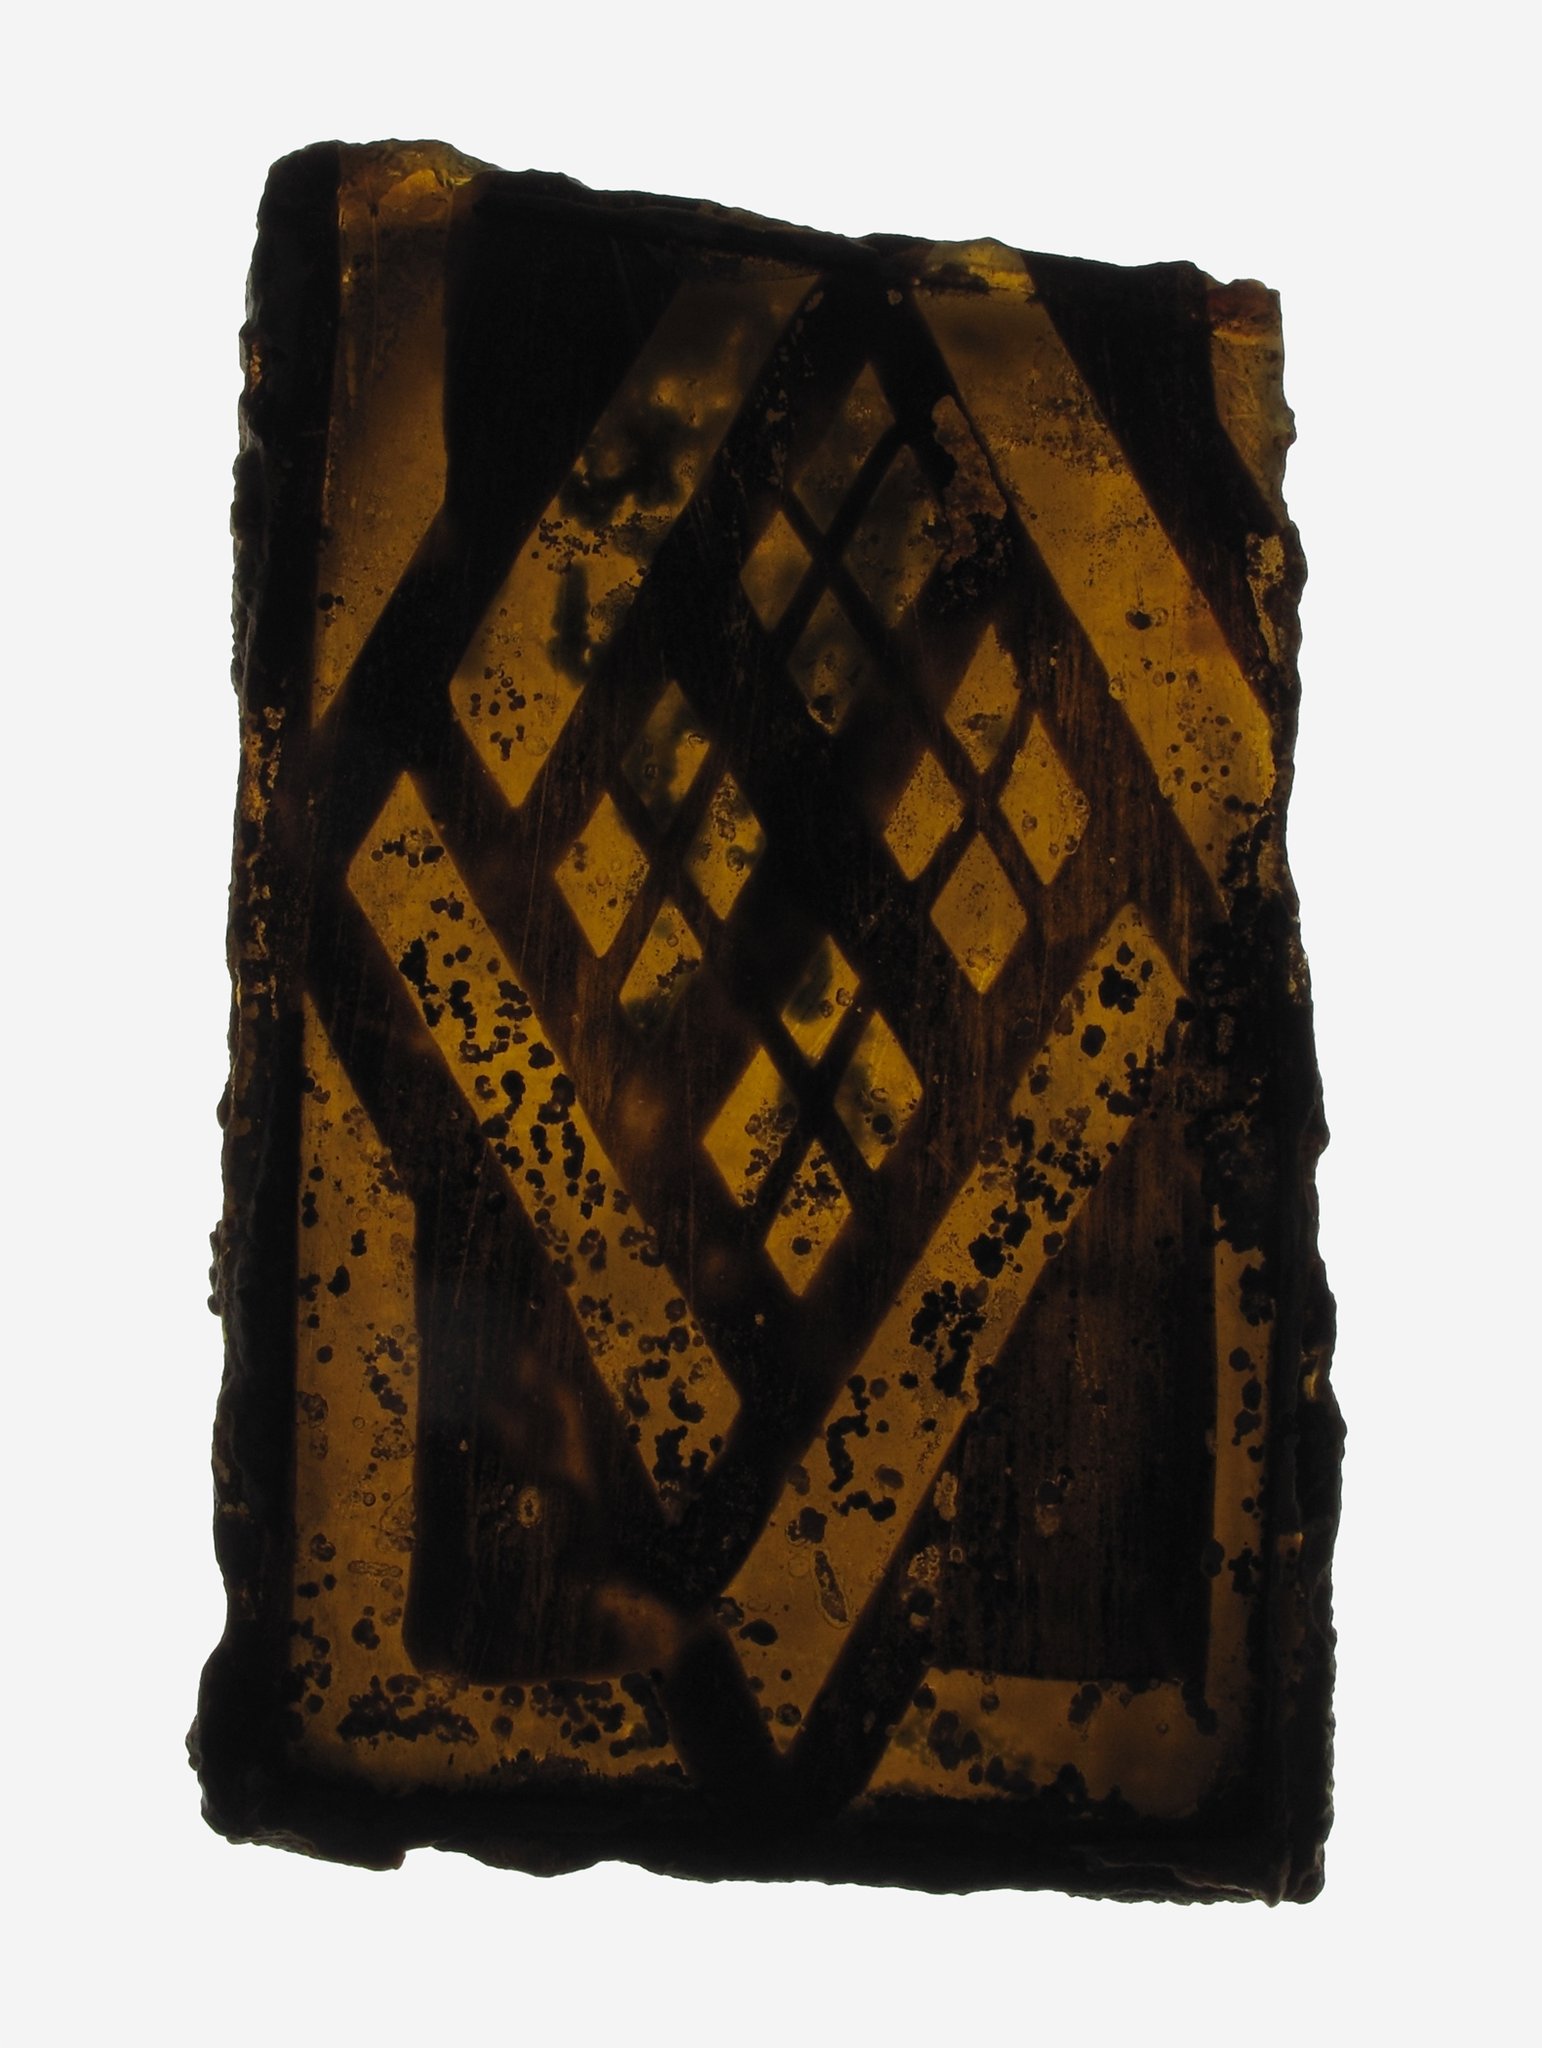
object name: fragment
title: Glass Fragment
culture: european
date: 1401-1500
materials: glass, metal